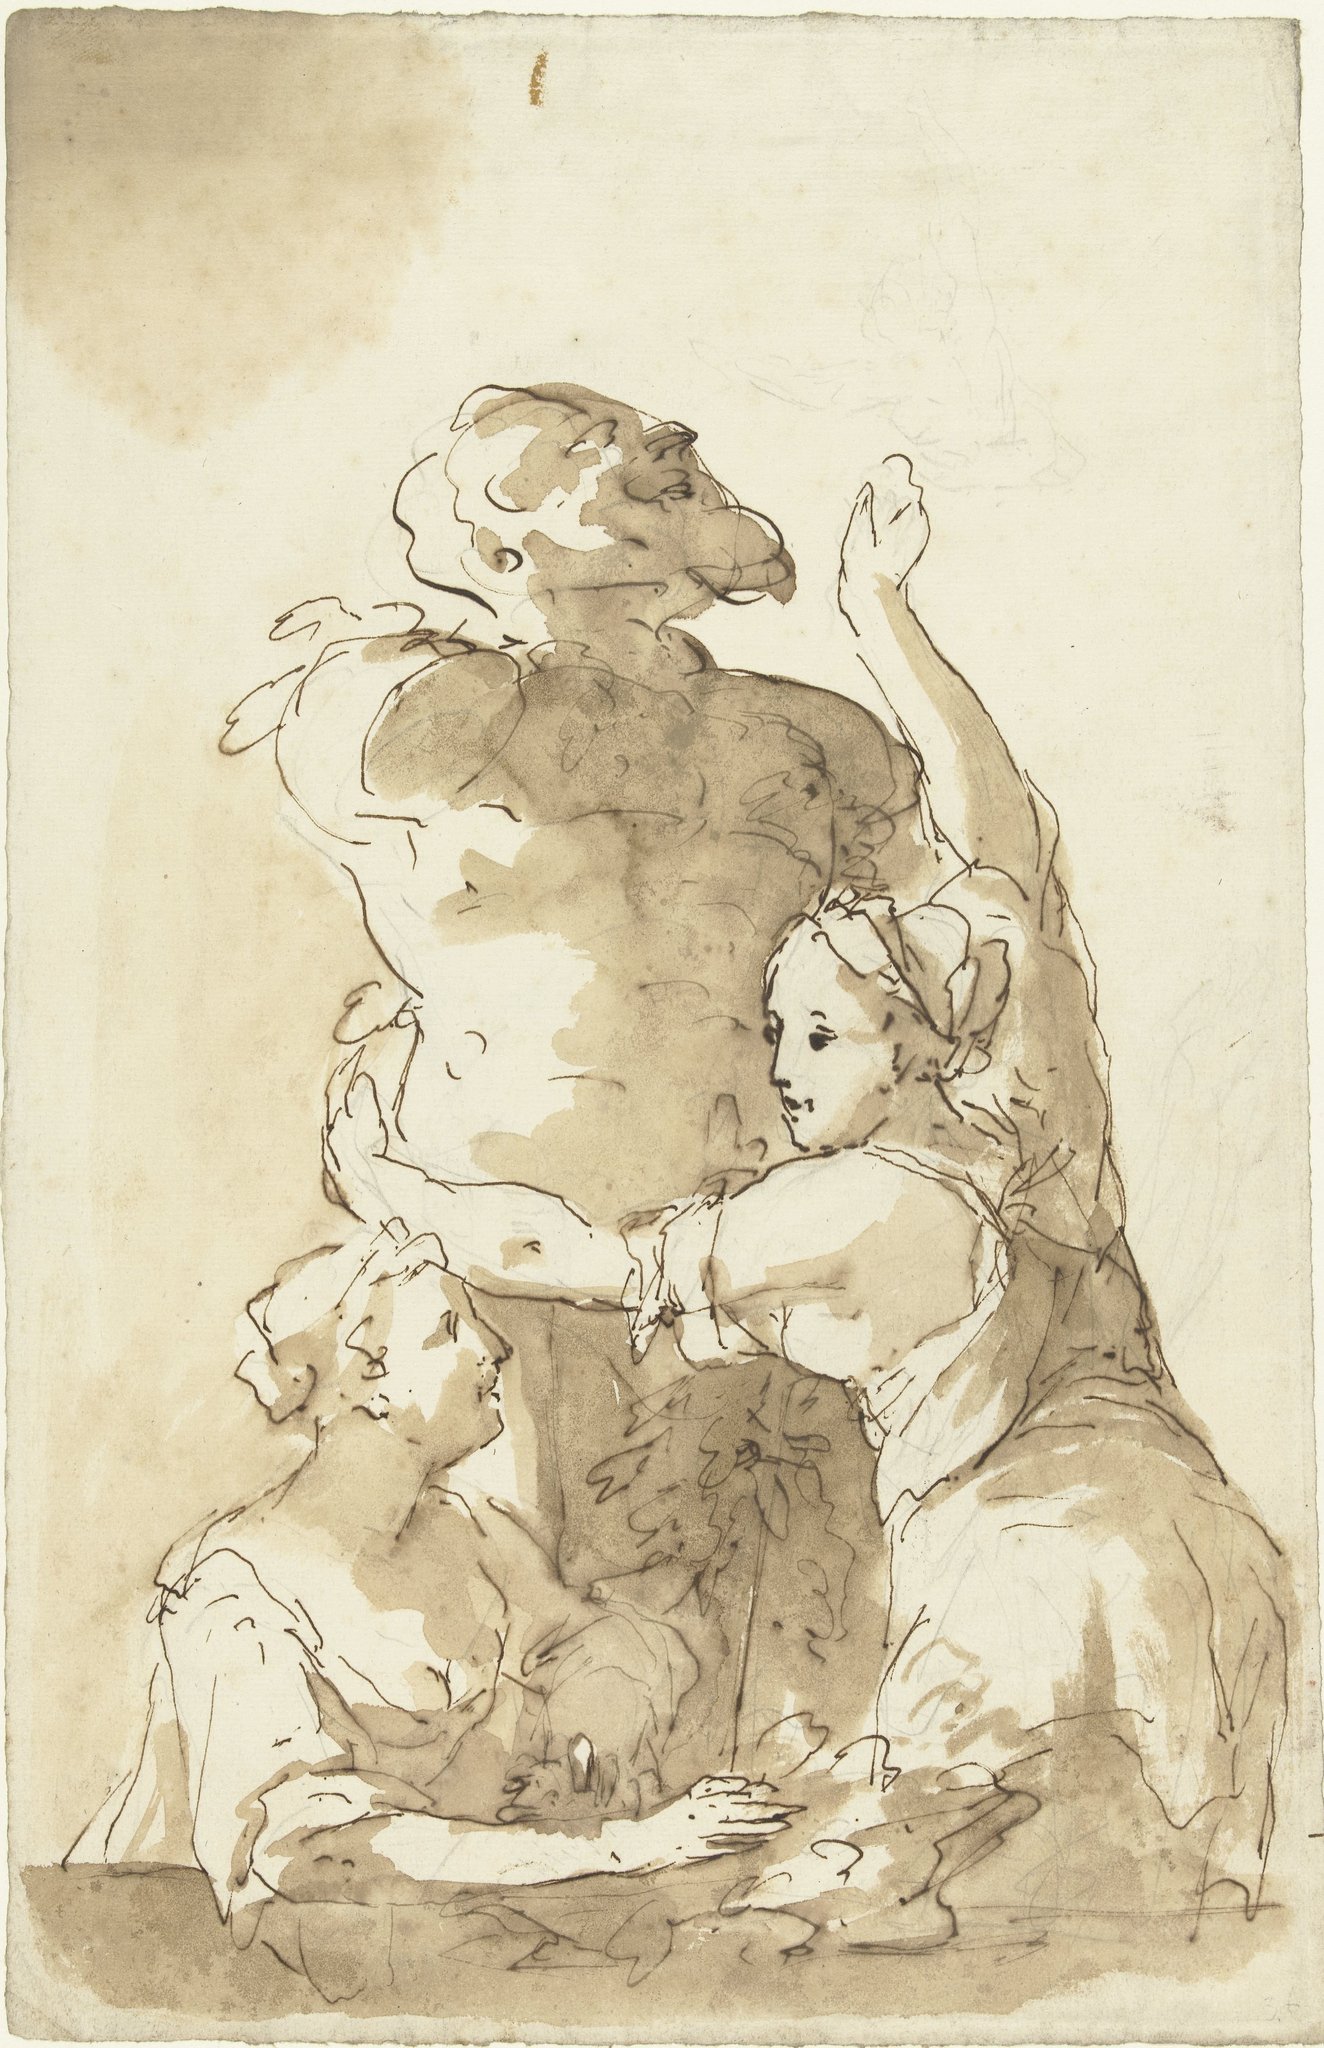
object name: design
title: Twee vrouwen, waarvan één een mansbeeld omhelst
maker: elias van nijmegen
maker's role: draughtsman, painter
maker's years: 1667-1755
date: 1677-1755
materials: ink, paper, pencil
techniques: brush, pen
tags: piece of sculpture, reproduction of a piece of sculpture